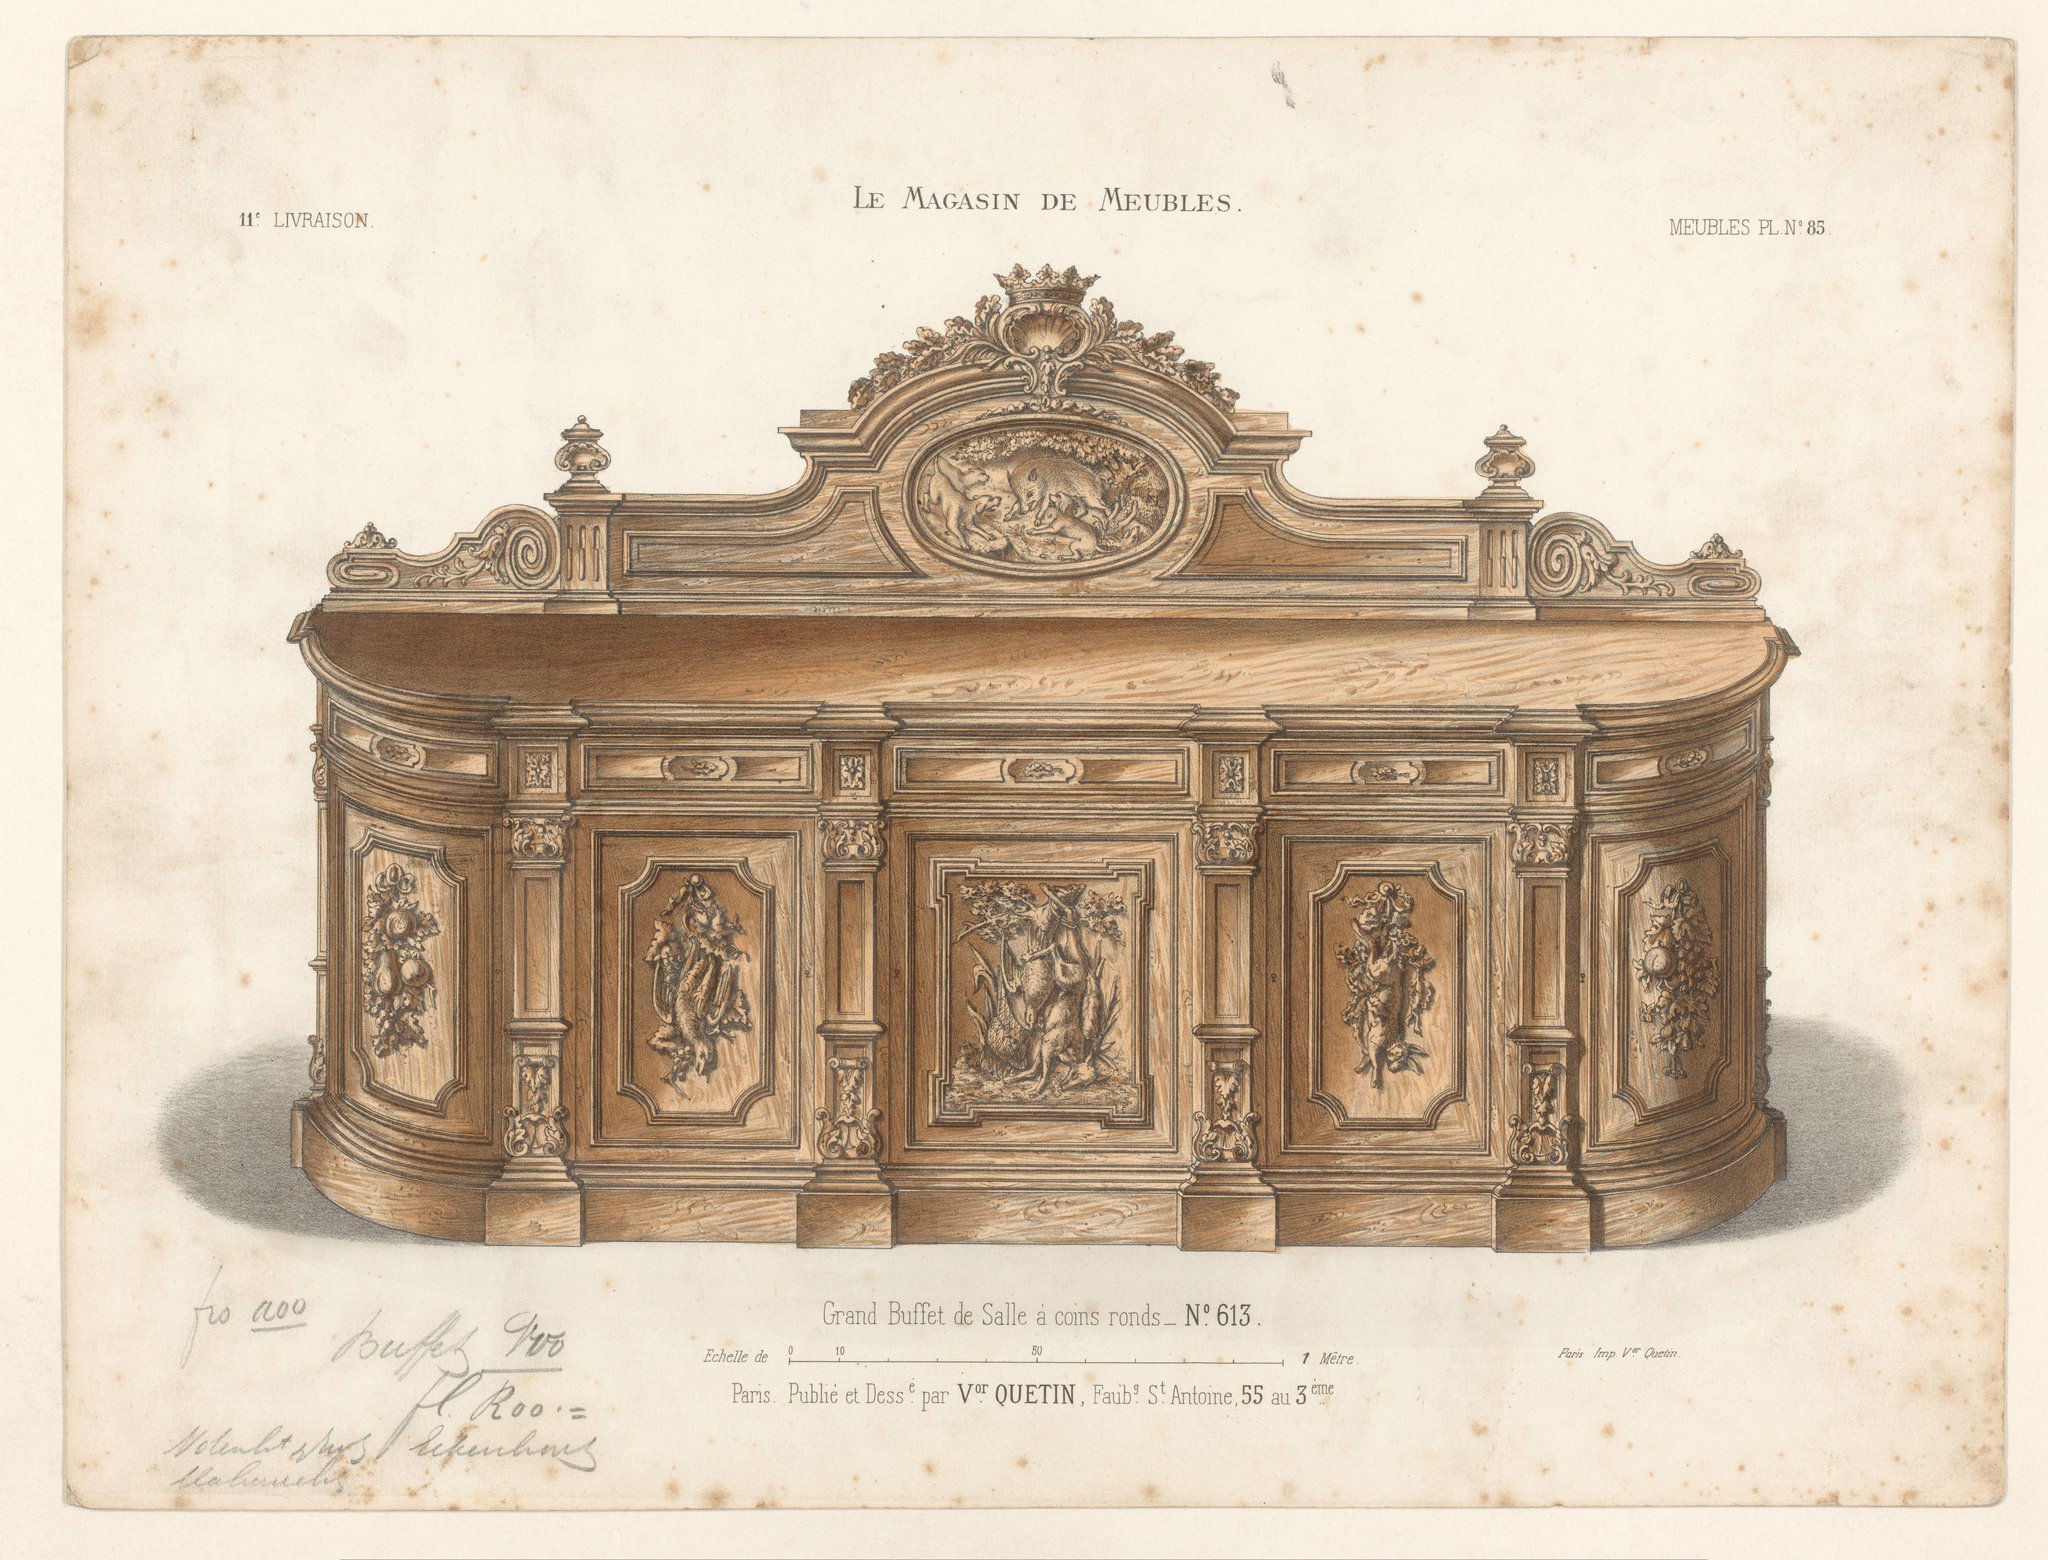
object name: print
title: Grand buffet de Salle à coins ronds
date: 1832-1877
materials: paper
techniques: hand coloring, lithograph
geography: paris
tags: furniture for storage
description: Een lage buffetkast geornamenteerd met jachttaferelen. Prent uit 11e Livraison.